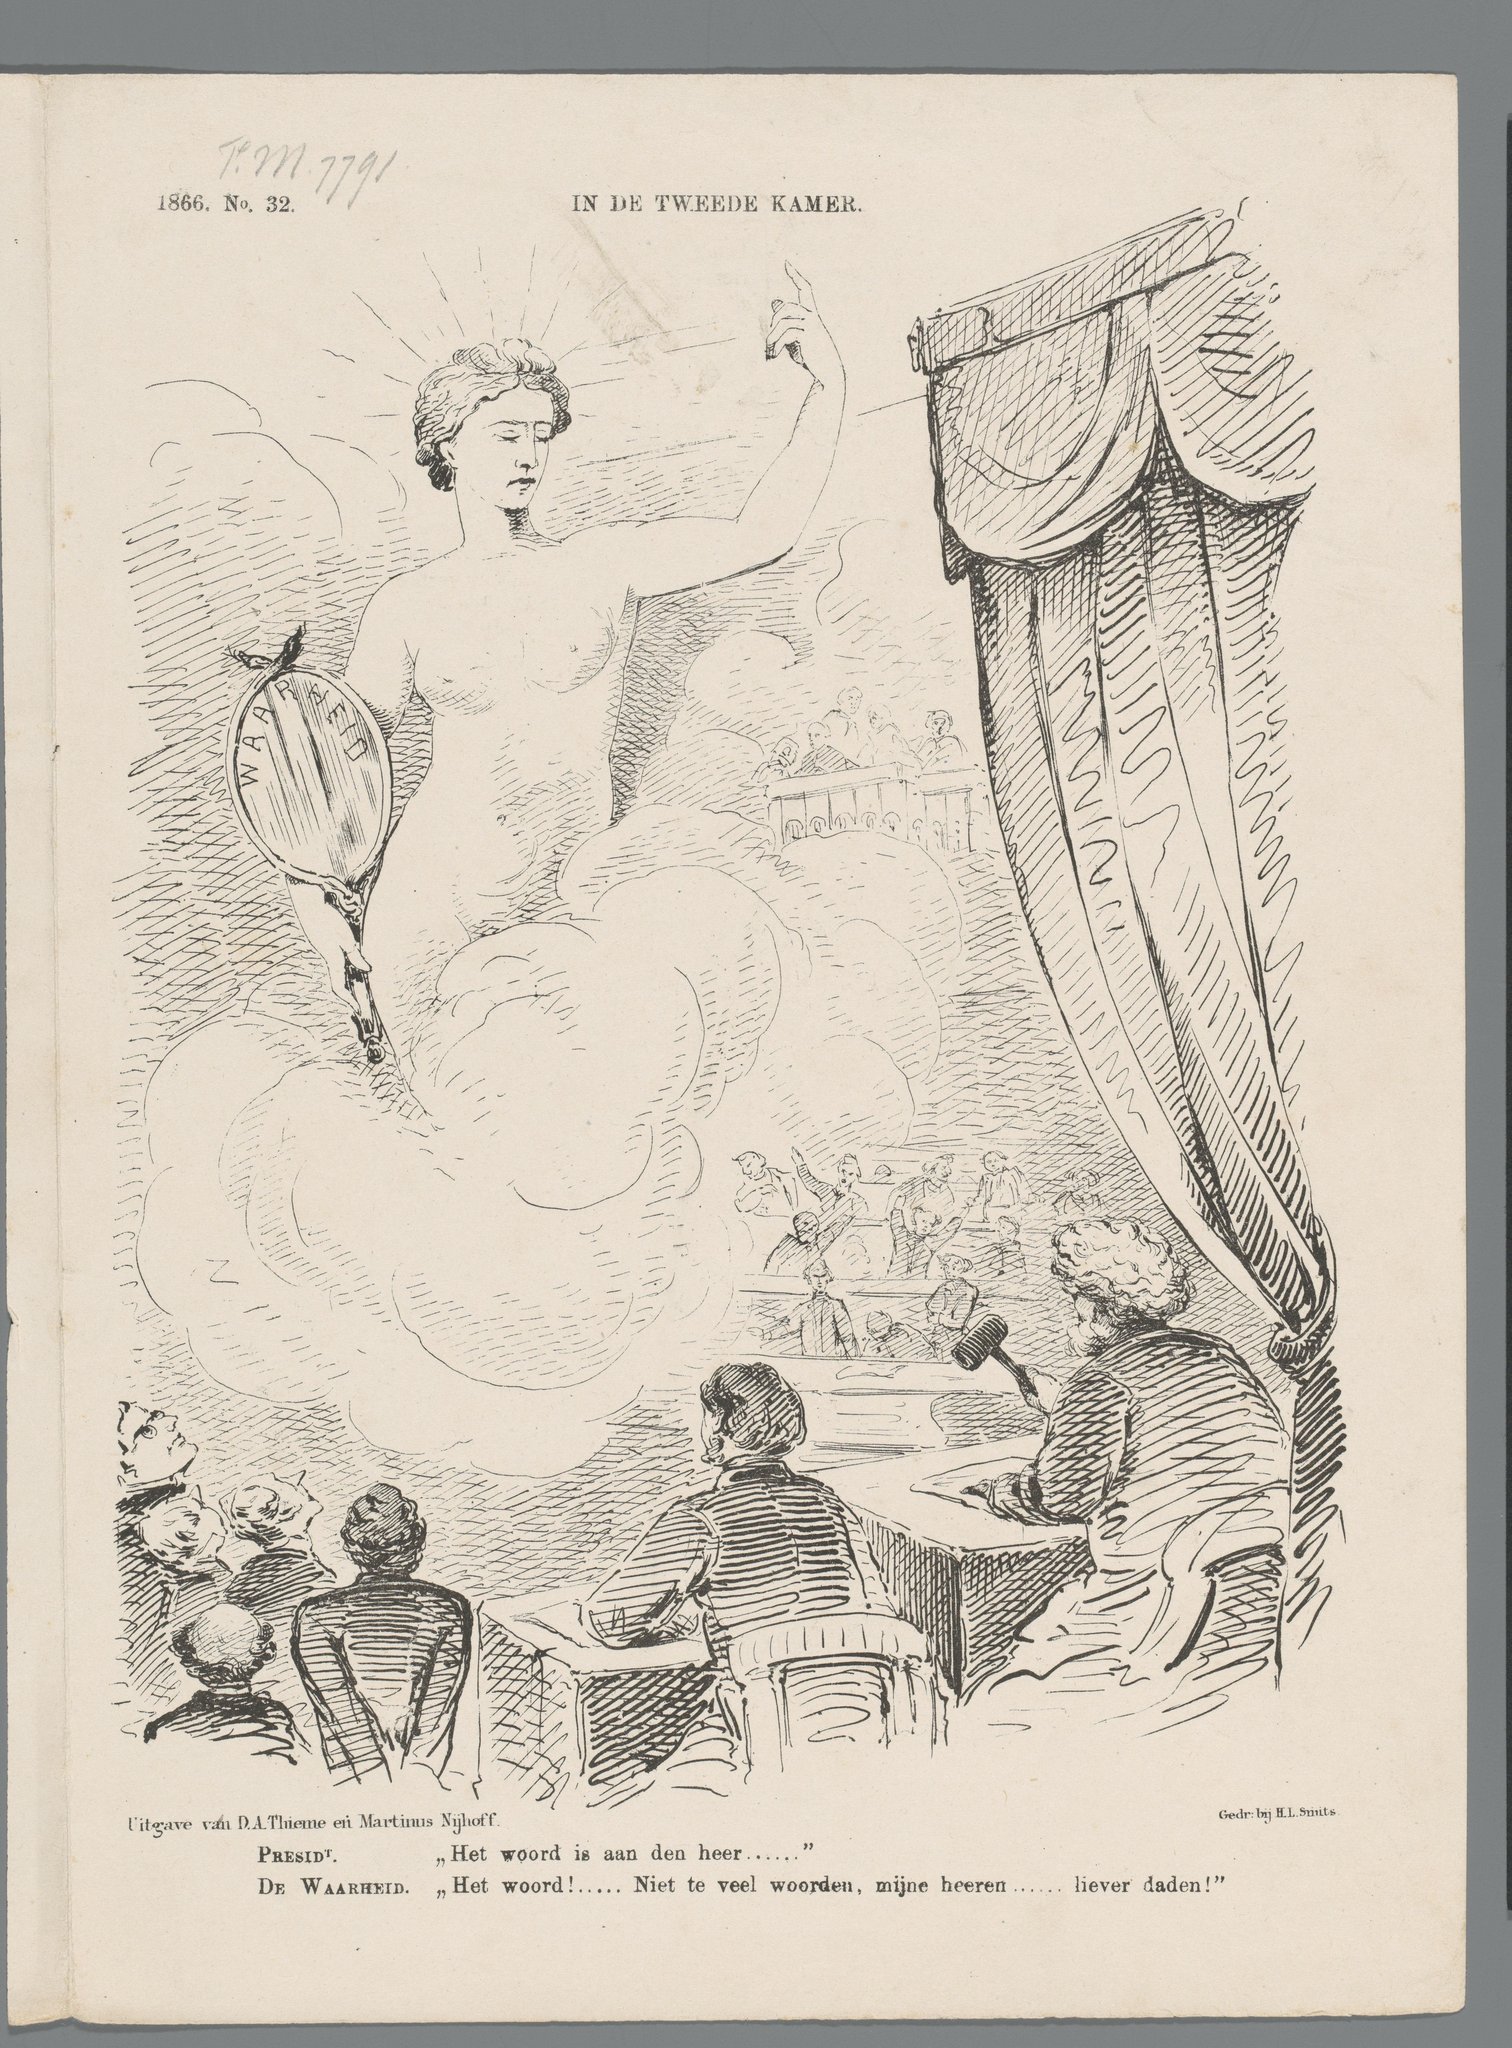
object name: cartoon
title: In de Tweede Kamer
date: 1866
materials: paper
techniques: lithograph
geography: netherlands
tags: truth; 'verità' (ripa)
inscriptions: collector's mark: Lugt 2228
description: Spotprent waarin de Waarheid verschijnt in de Tweede Kamer met de aanmaning minder te spreken en meer te doen. Plaat verschenen bij het weekblad De Nederlandsche Spectator, nr. 32, 11 augustus 1866.